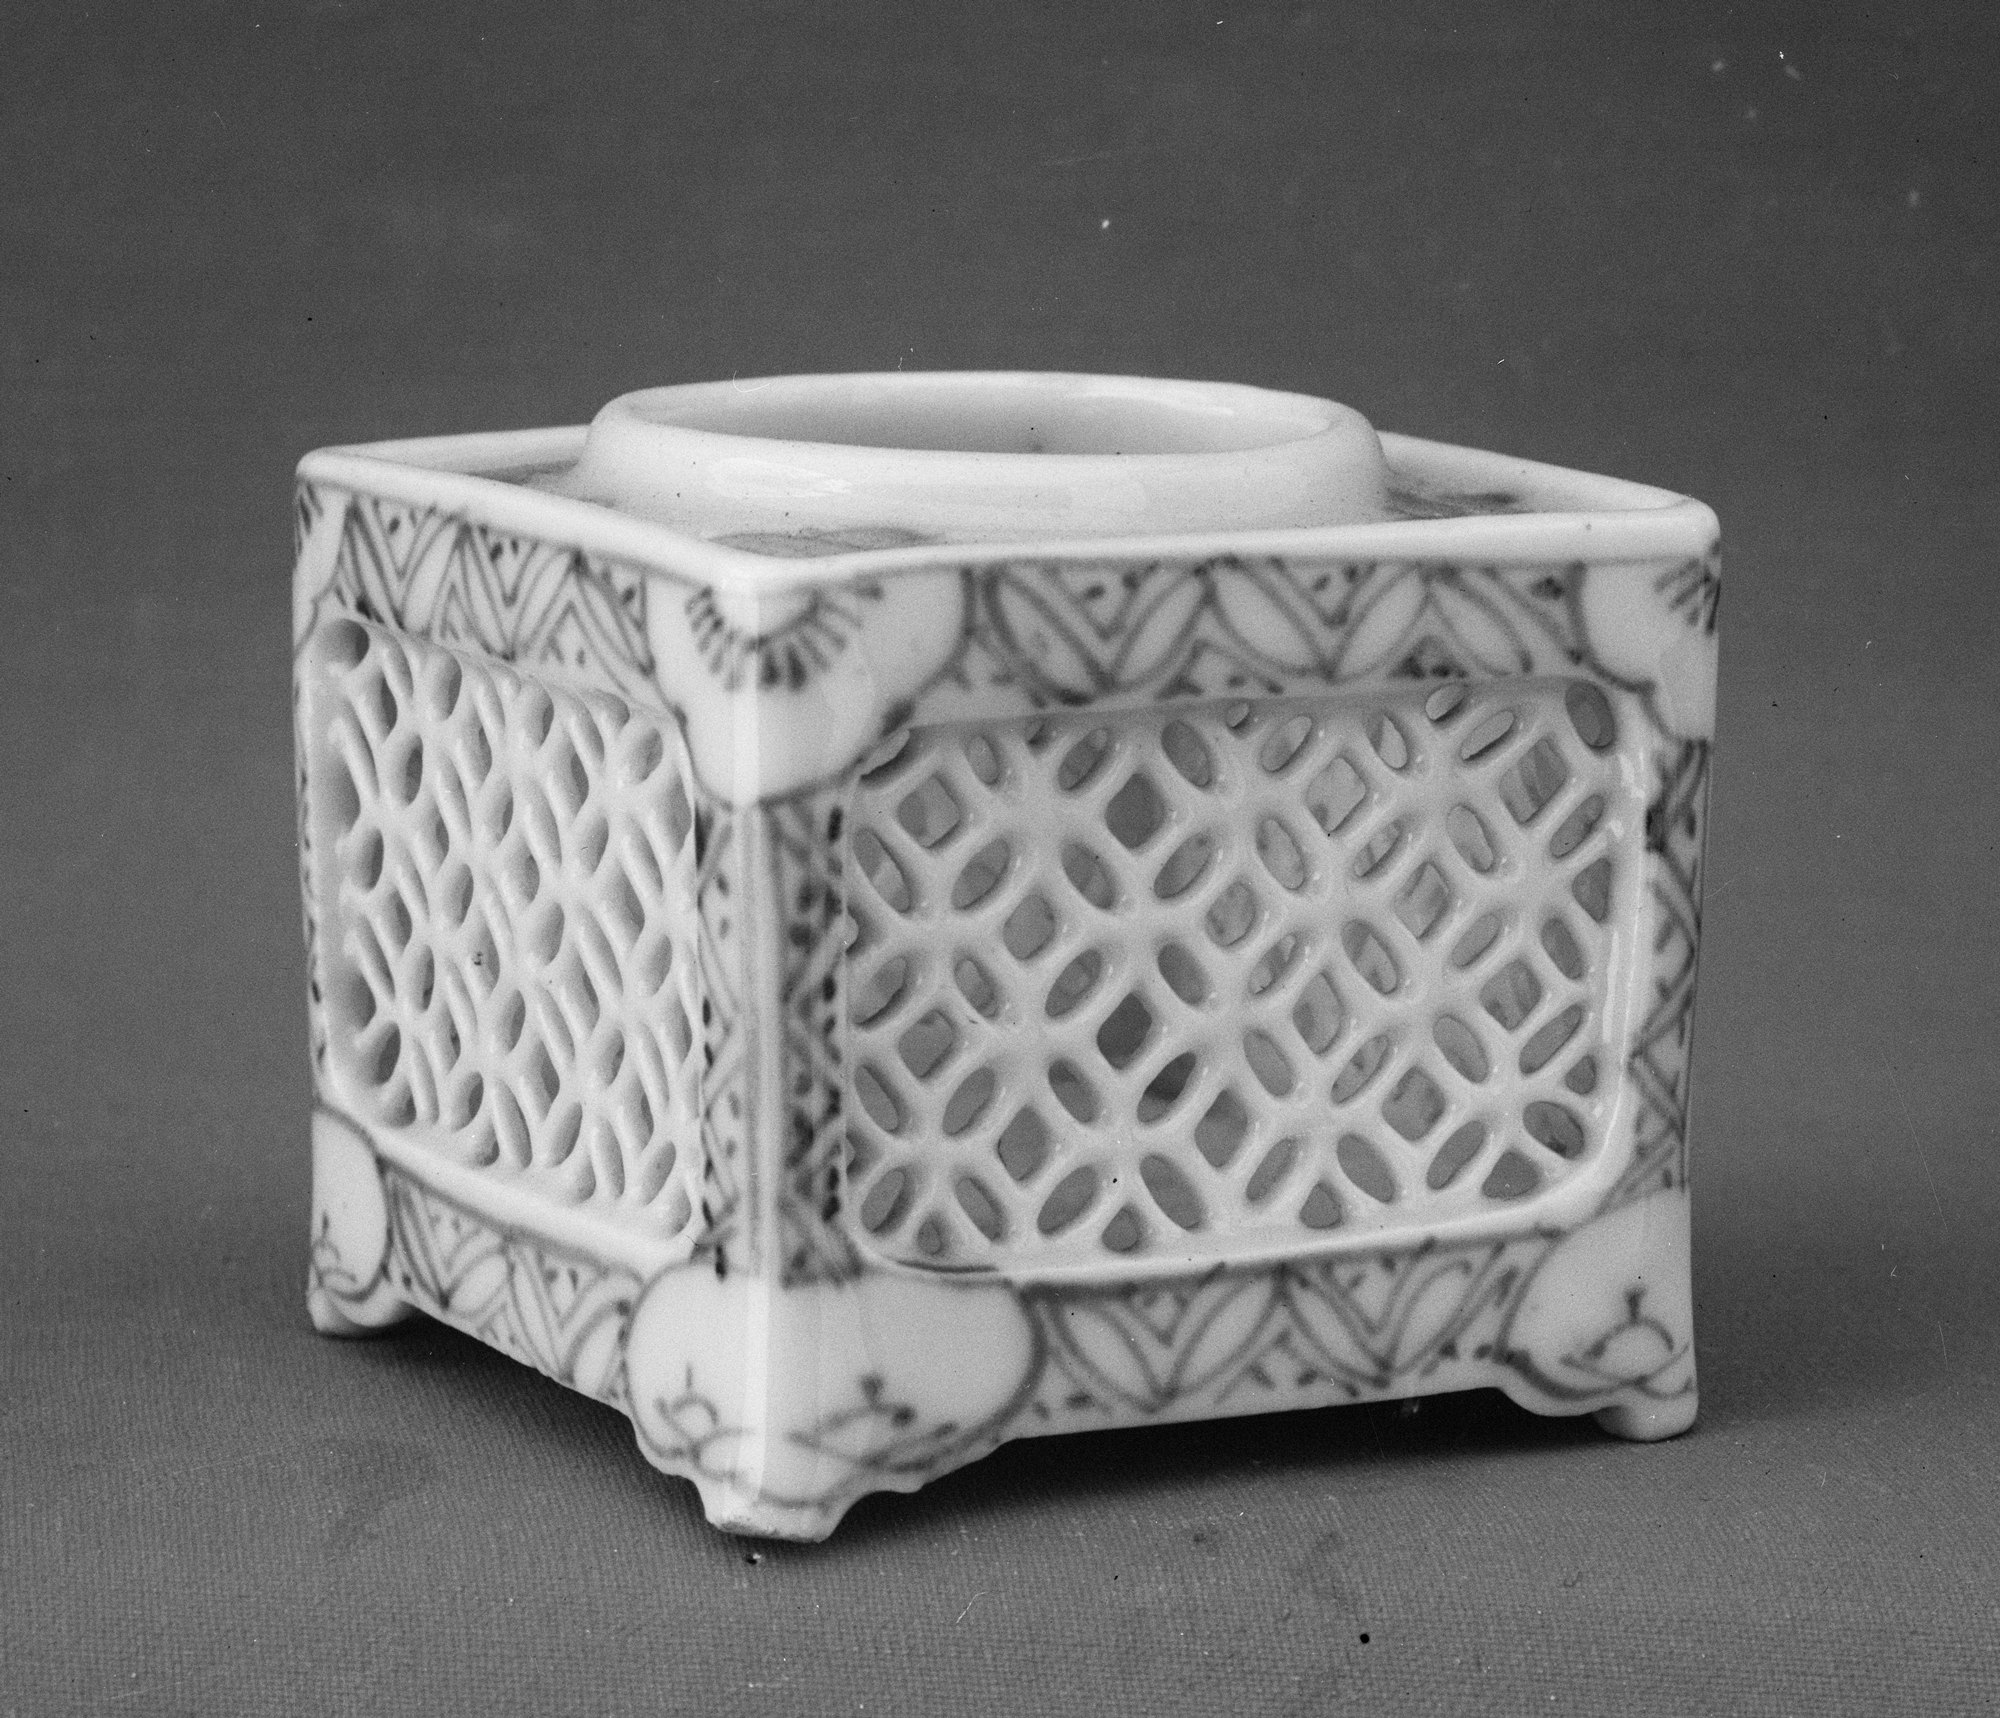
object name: cup stand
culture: japanese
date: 1801-1900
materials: glaze, porcelain